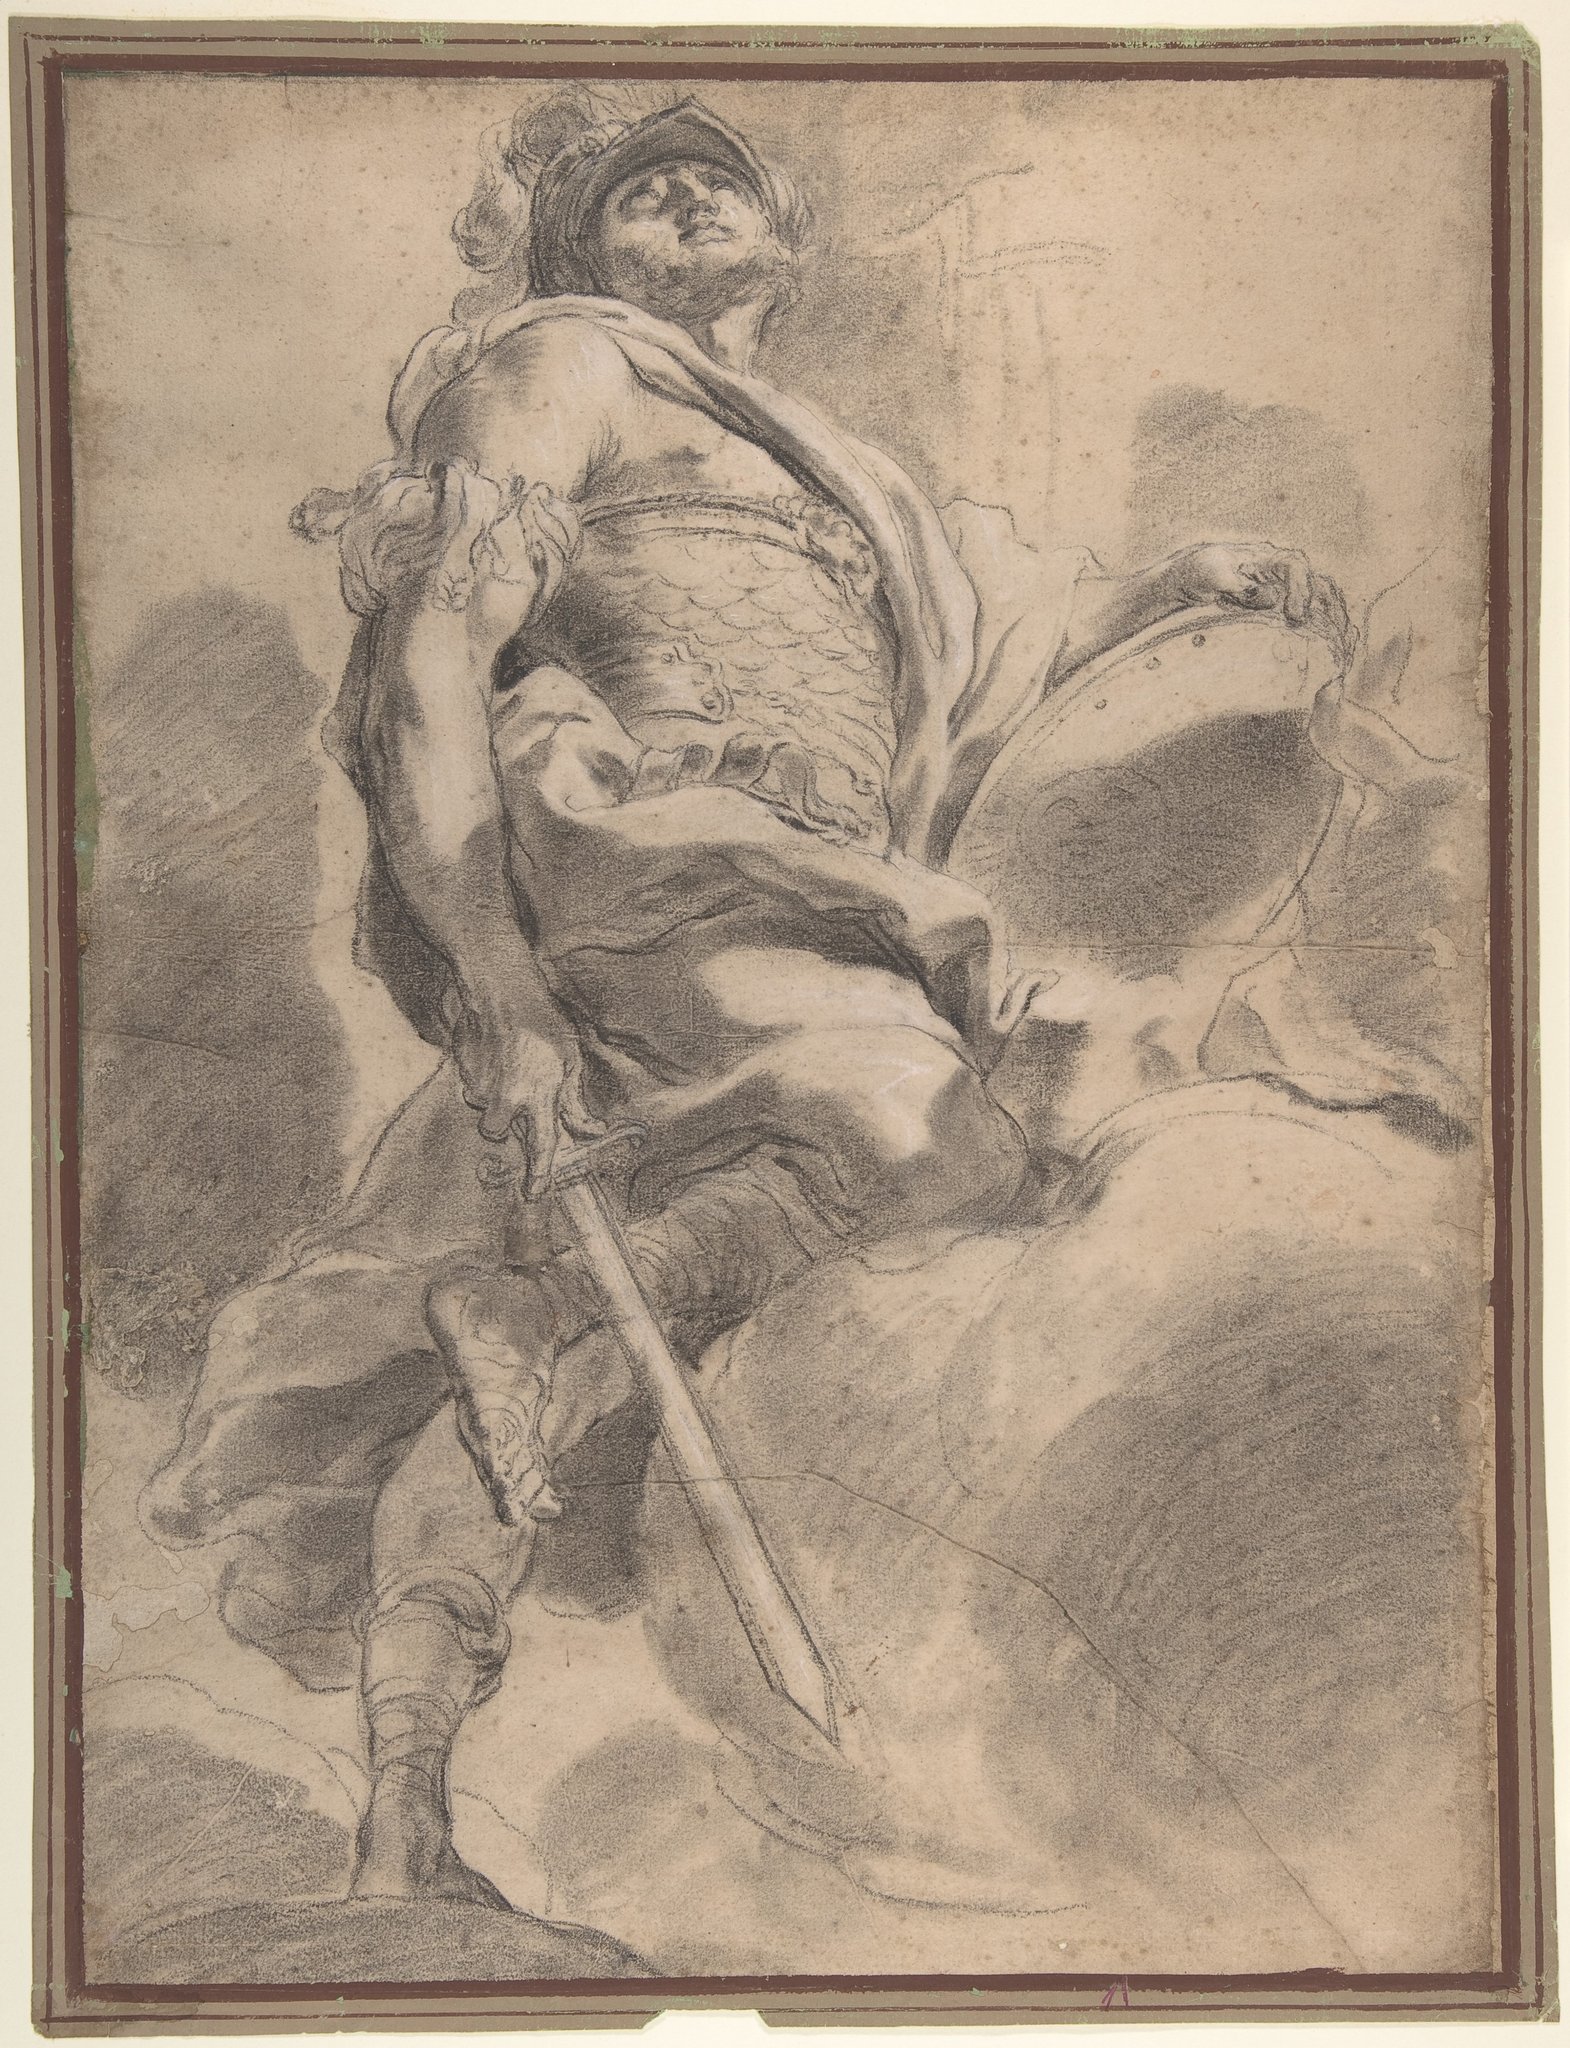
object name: drawing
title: Joshua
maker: gaetano gandolfi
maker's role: artist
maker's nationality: italian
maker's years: 1734-1802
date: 1779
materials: chalk, paper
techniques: brush, highlighting, stumping, wash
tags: shields,swords,joshua